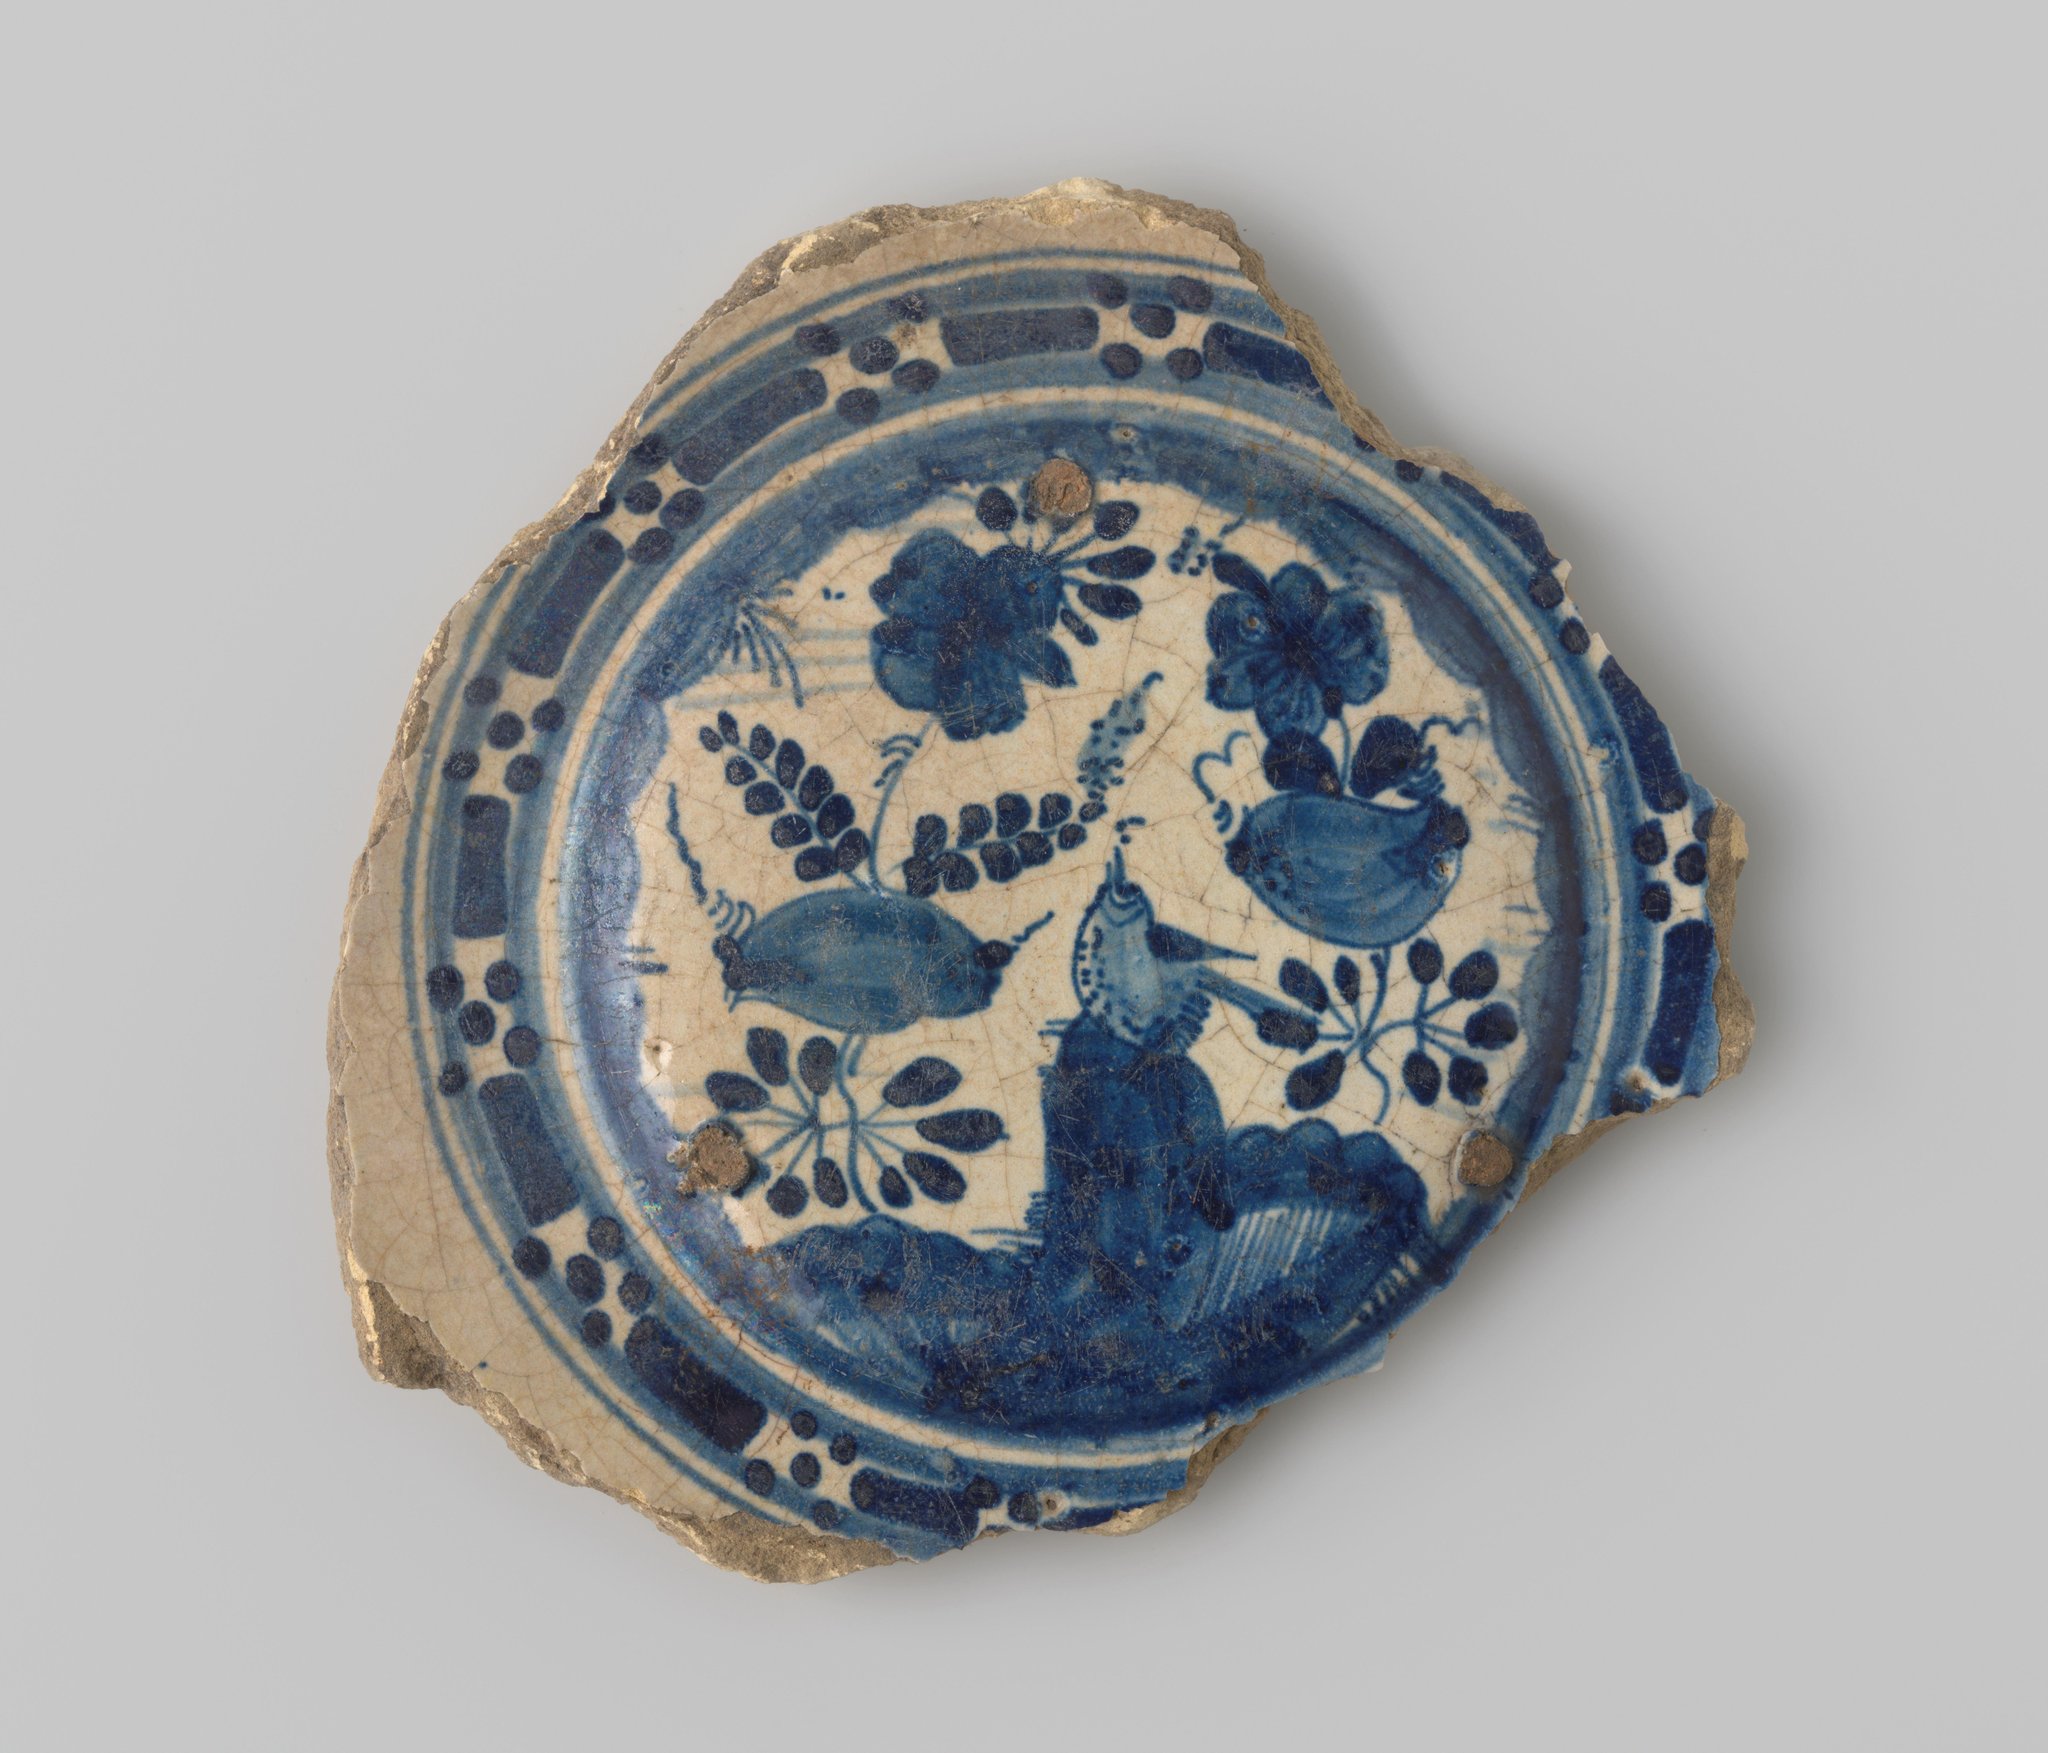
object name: sherd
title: Schotelfragment van aardewerk voorzien van loodglazuur aan de achterzijde en tinglazuur met blauwe decoratie aan de voorzijde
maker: Anonymous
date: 1600-1620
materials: earthenware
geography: northern netherlands